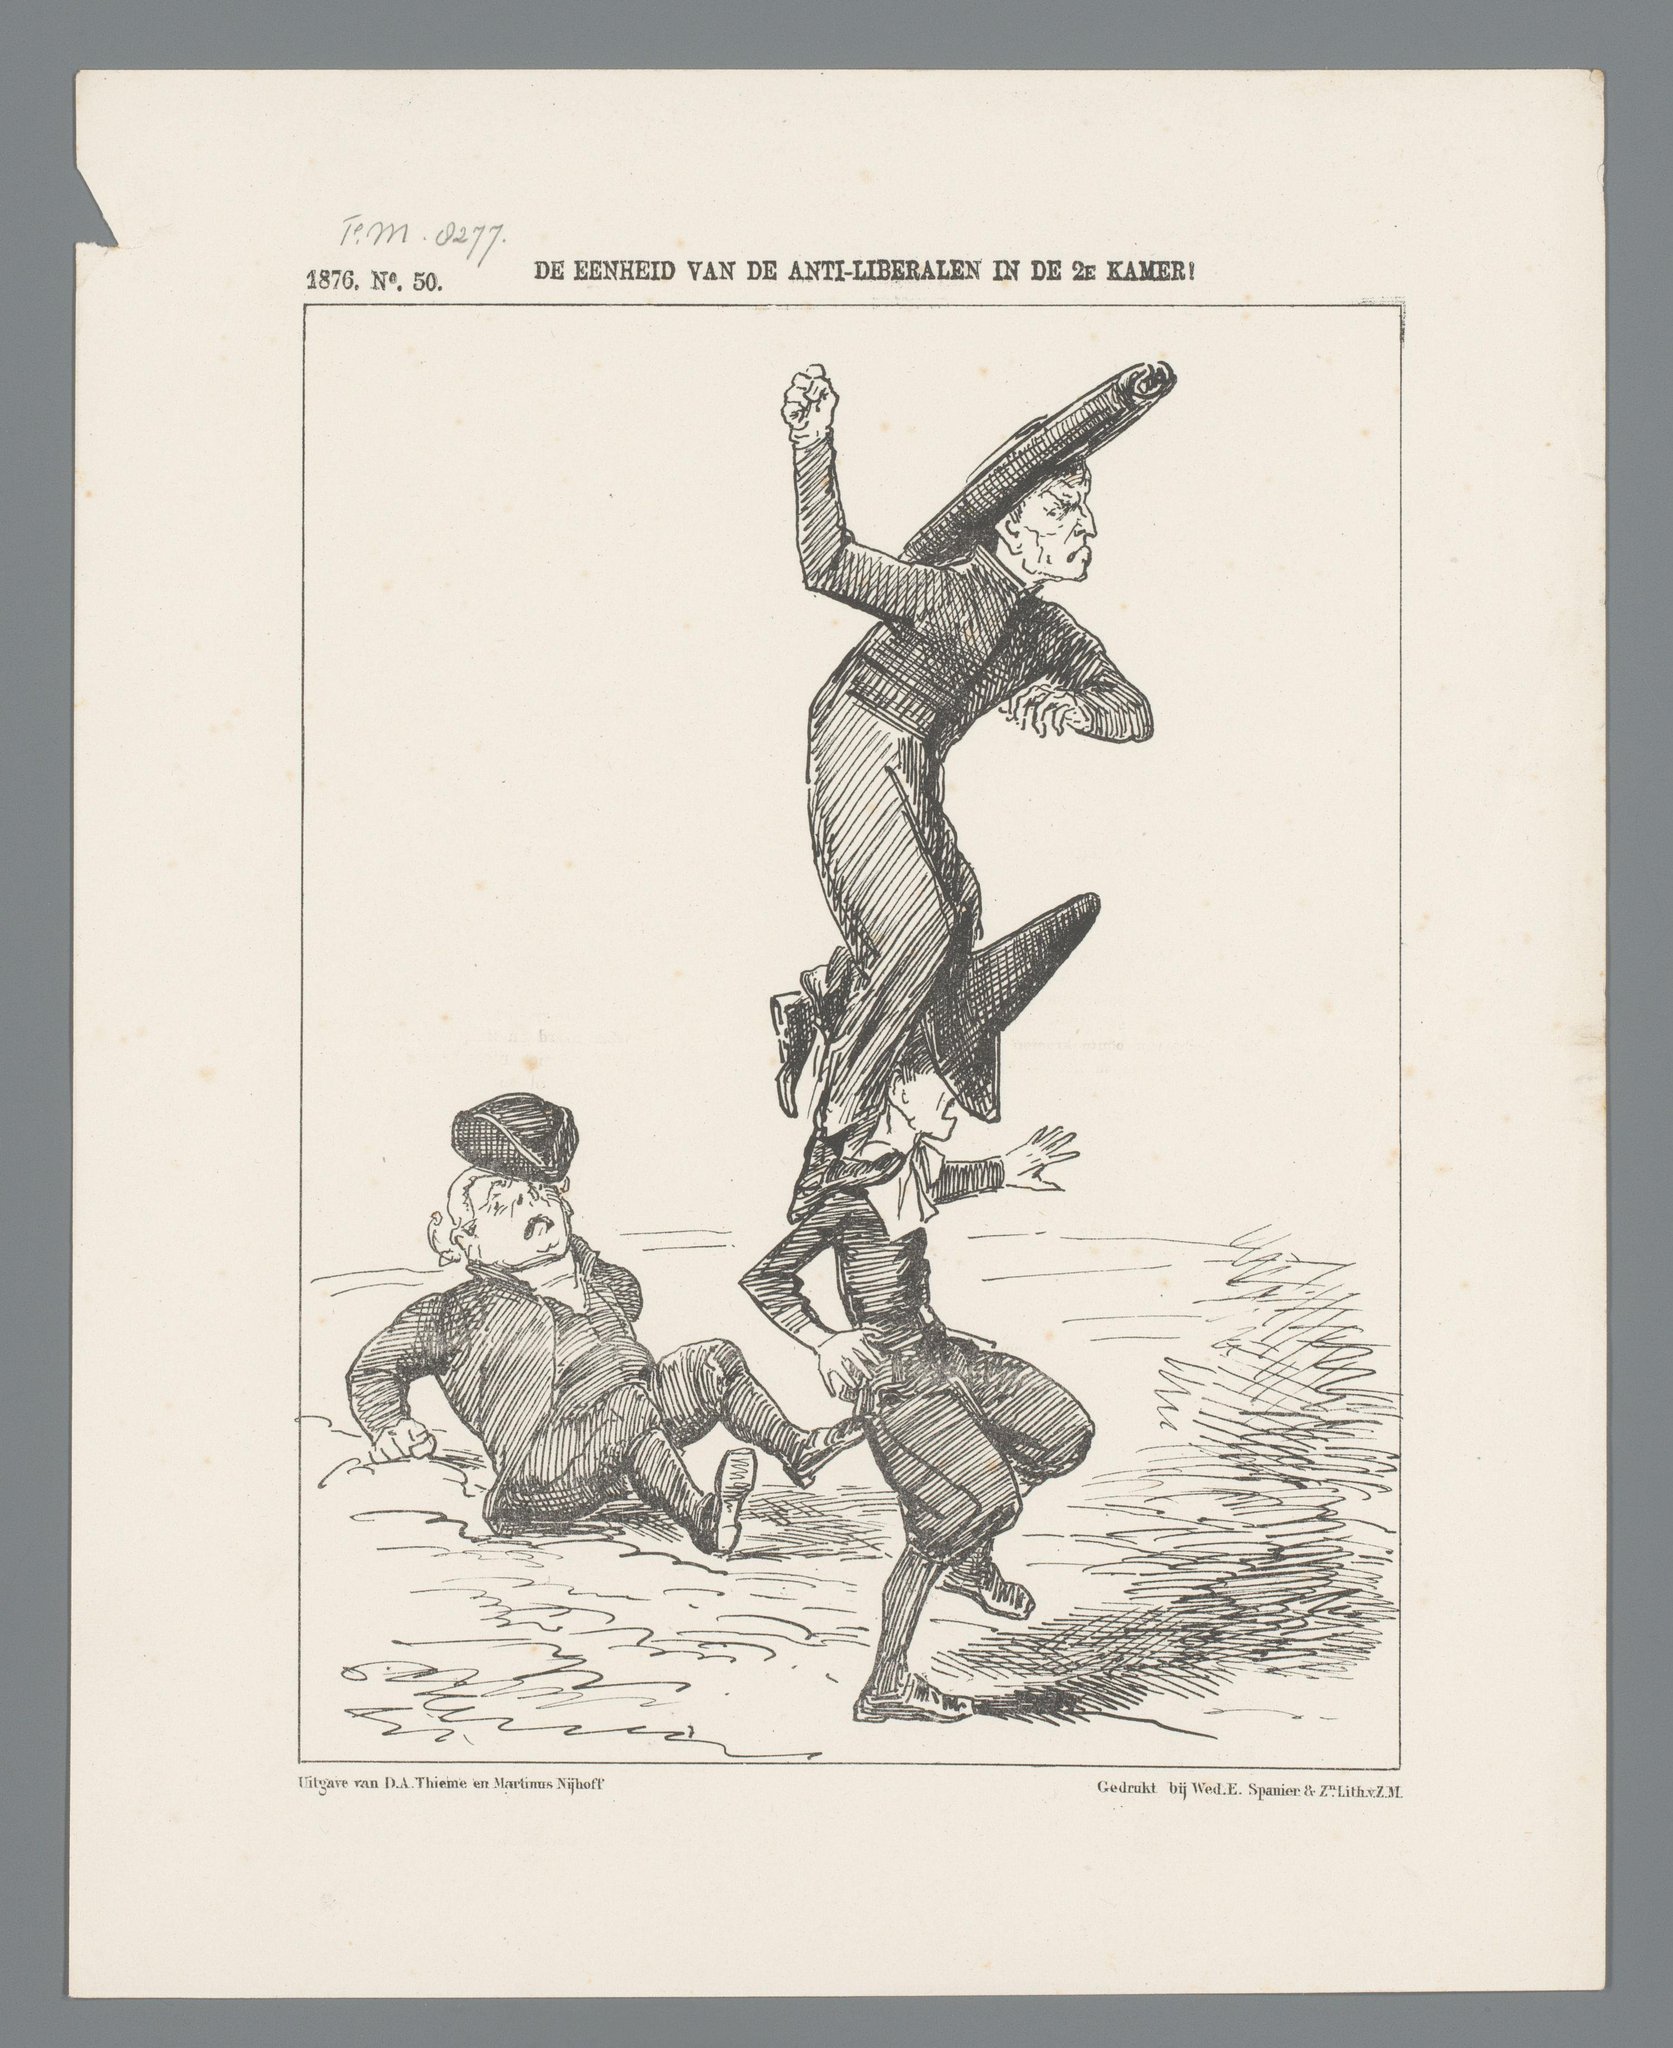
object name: print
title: De eenheid van de anti-liberalen in de 2e Kamer!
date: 1876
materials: paper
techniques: lithograph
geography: arnhem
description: Spotprent . Plaat verschenen bij het weekblad De Nederlandsche Spectator, nr. 50, 1876.